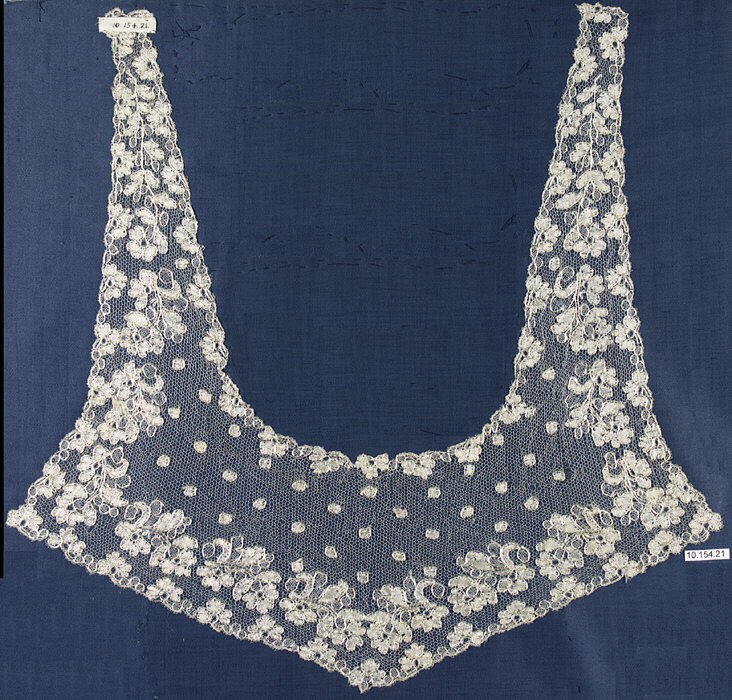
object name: collar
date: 1801-1900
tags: flowers